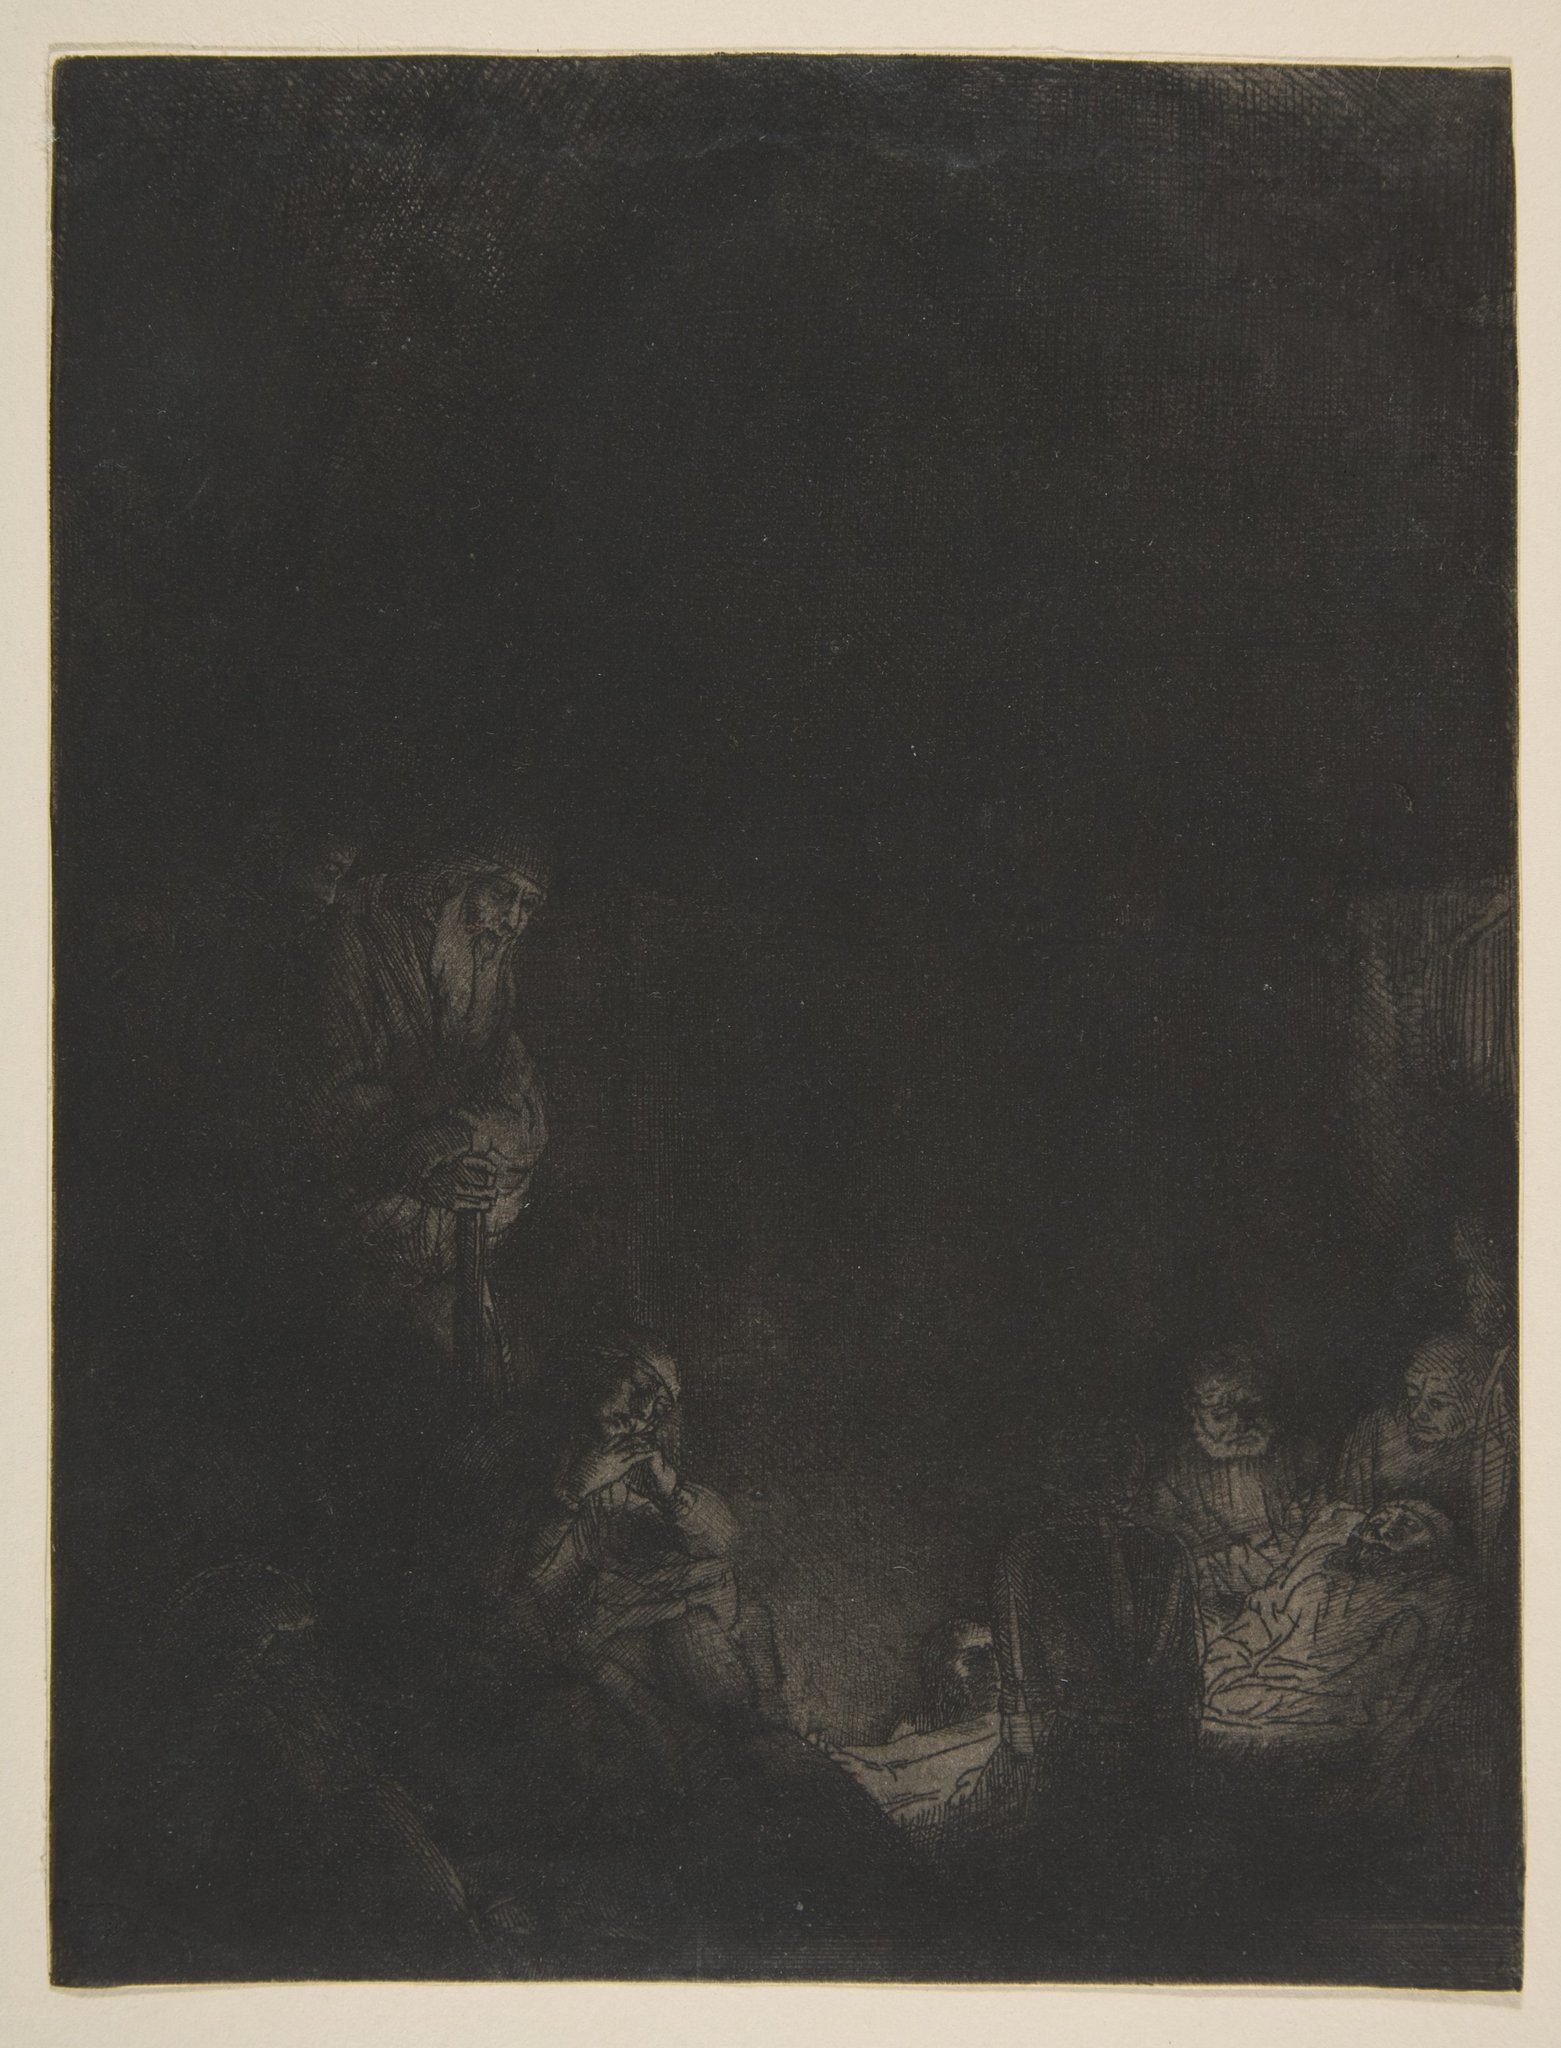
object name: print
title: The Entombment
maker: rembrandt van rijn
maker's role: artist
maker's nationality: dutch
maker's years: 1606-1669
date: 1654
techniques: drypoint, engraving, etching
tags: men,women,christ,entombment